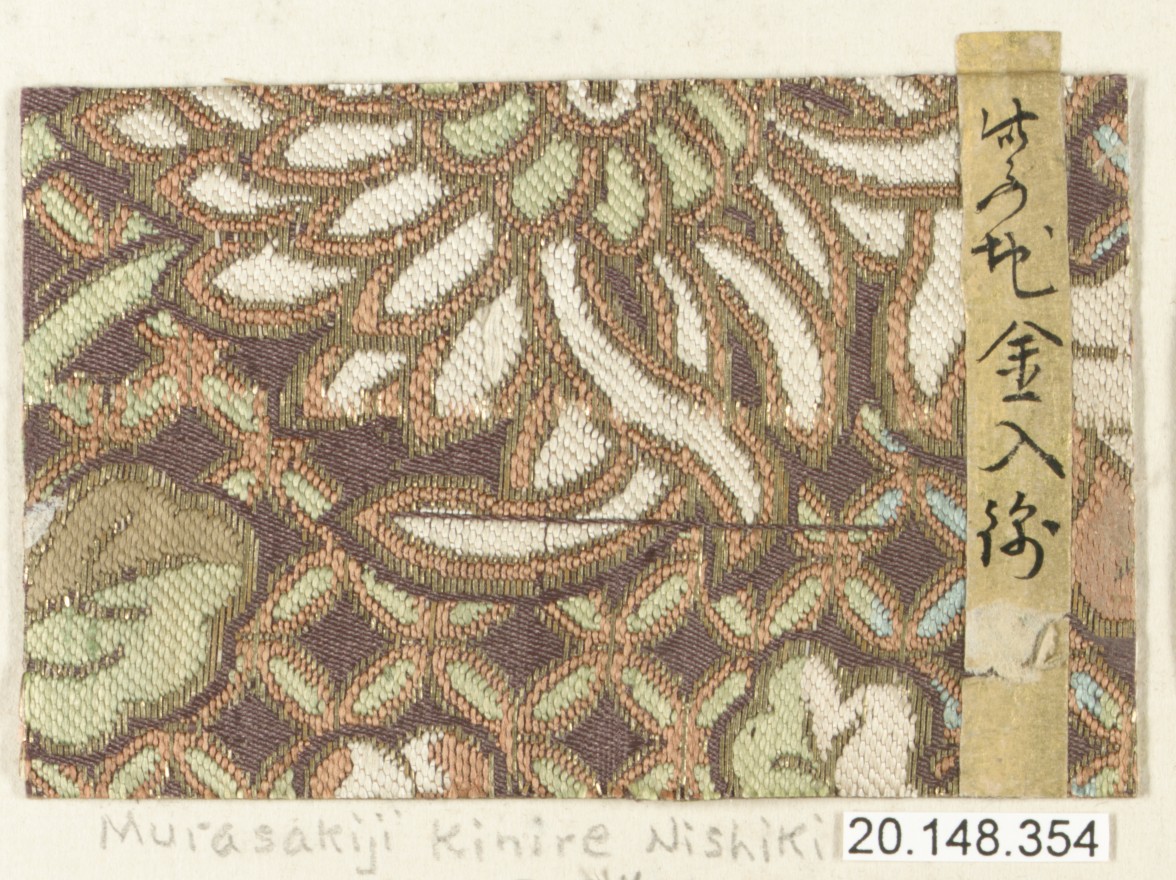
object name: piece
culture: japanese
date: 1601-1700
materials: silk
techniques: compound weave